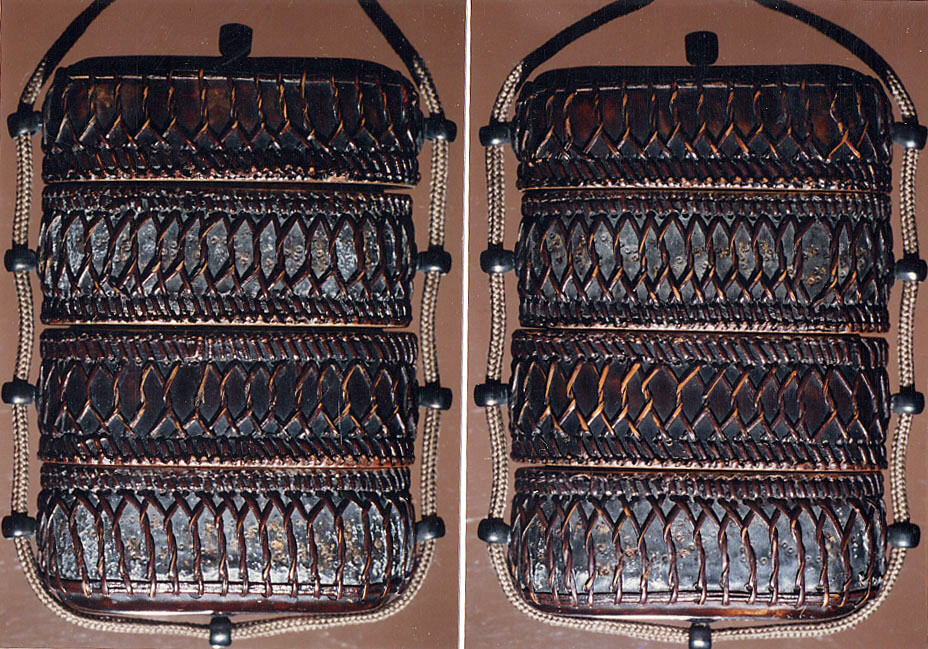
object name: inrō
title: Tortoiseshell and Basketry Inrō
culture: japanese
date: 1601-1700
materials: bamboo, bronze, ivory, lacquer, rattan, shell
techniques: stain, urushi